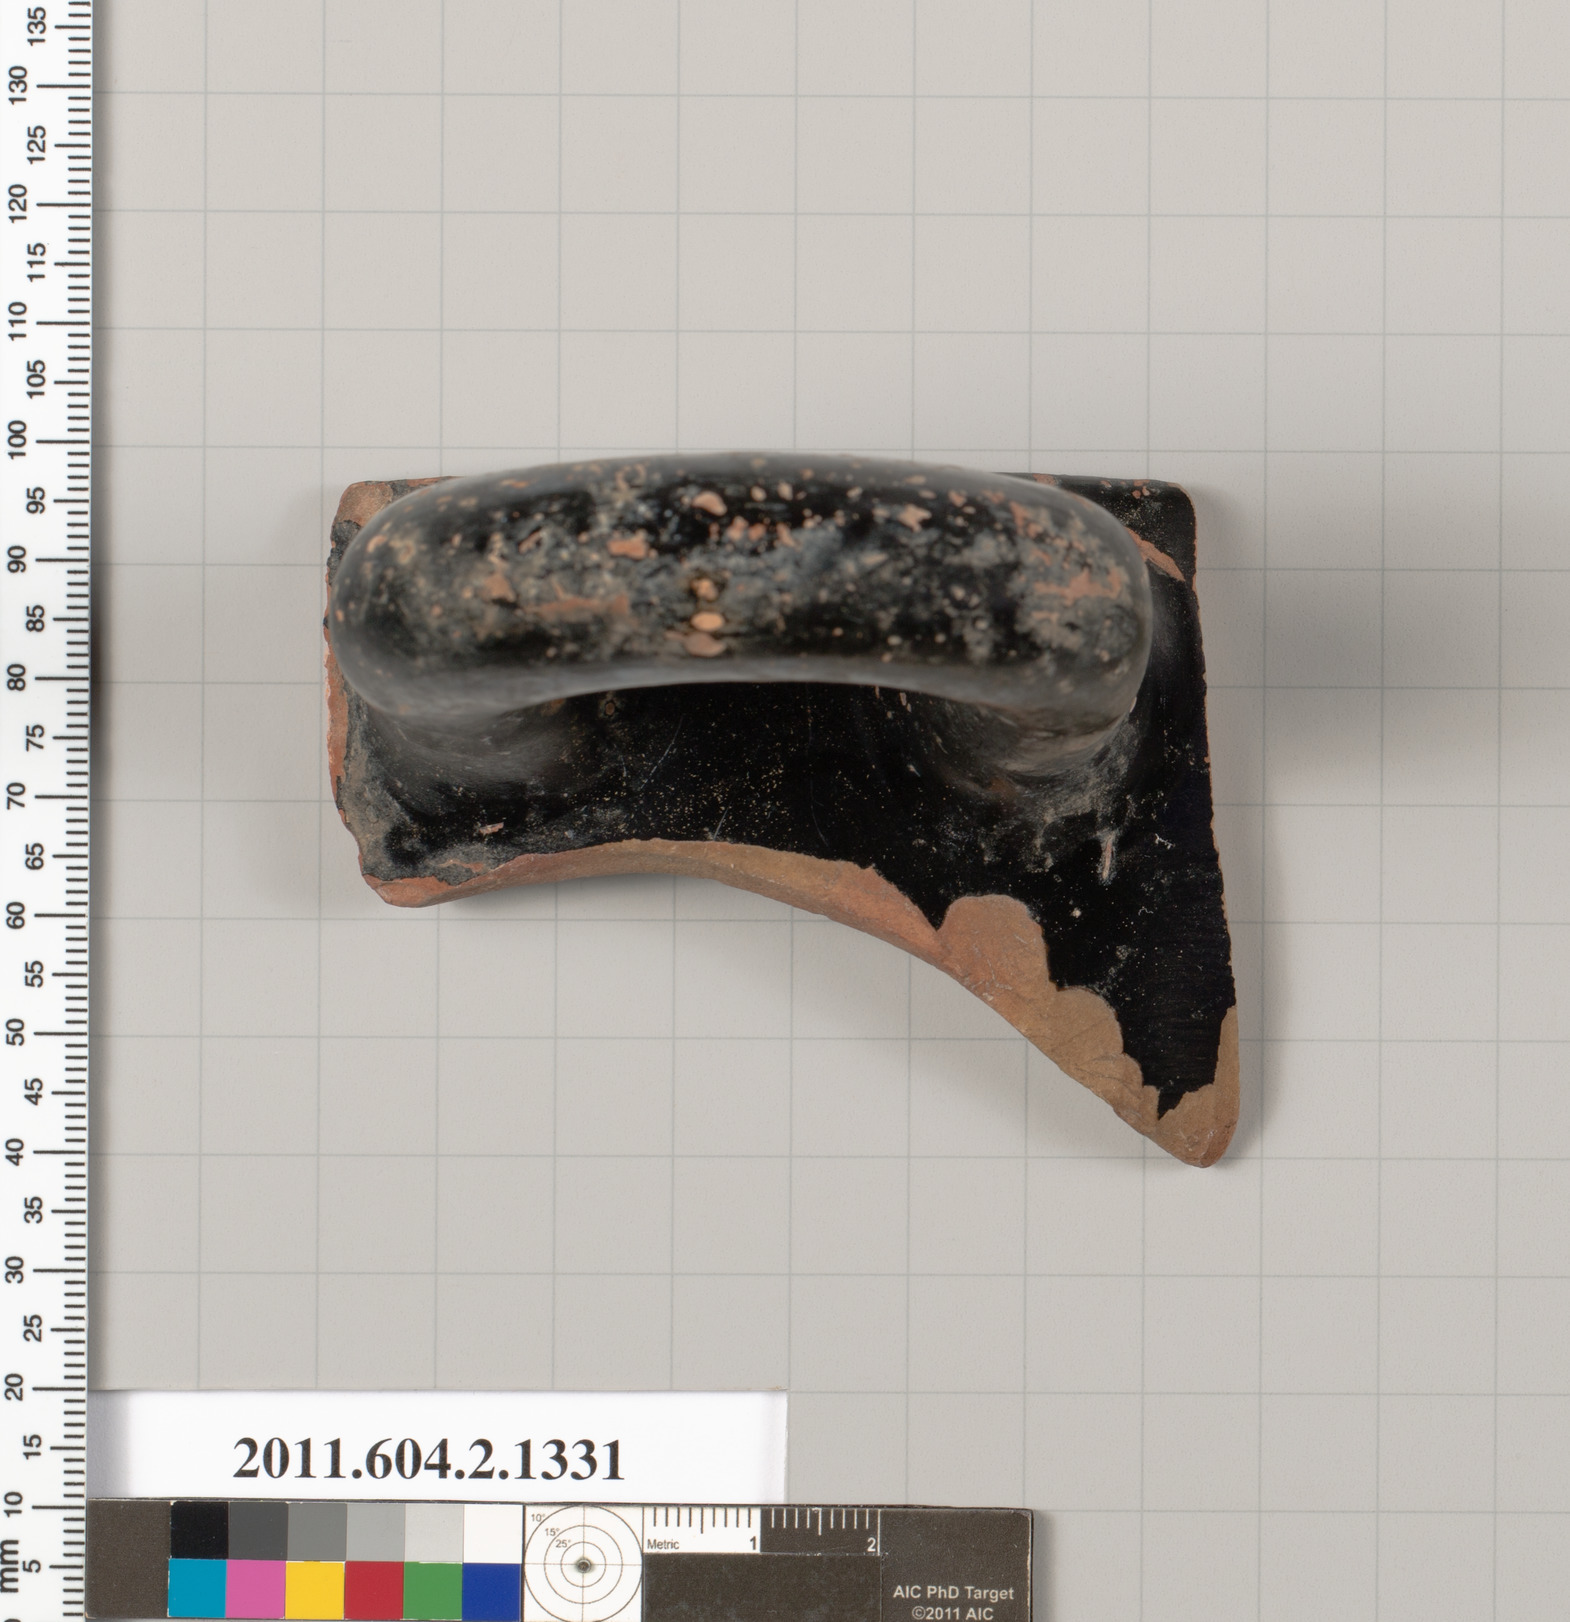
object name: skyphos fragment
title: Terracotta fragment of a skyphos (deep drinking cup)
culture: greek, attic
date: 500-451 BCE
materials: terracotta